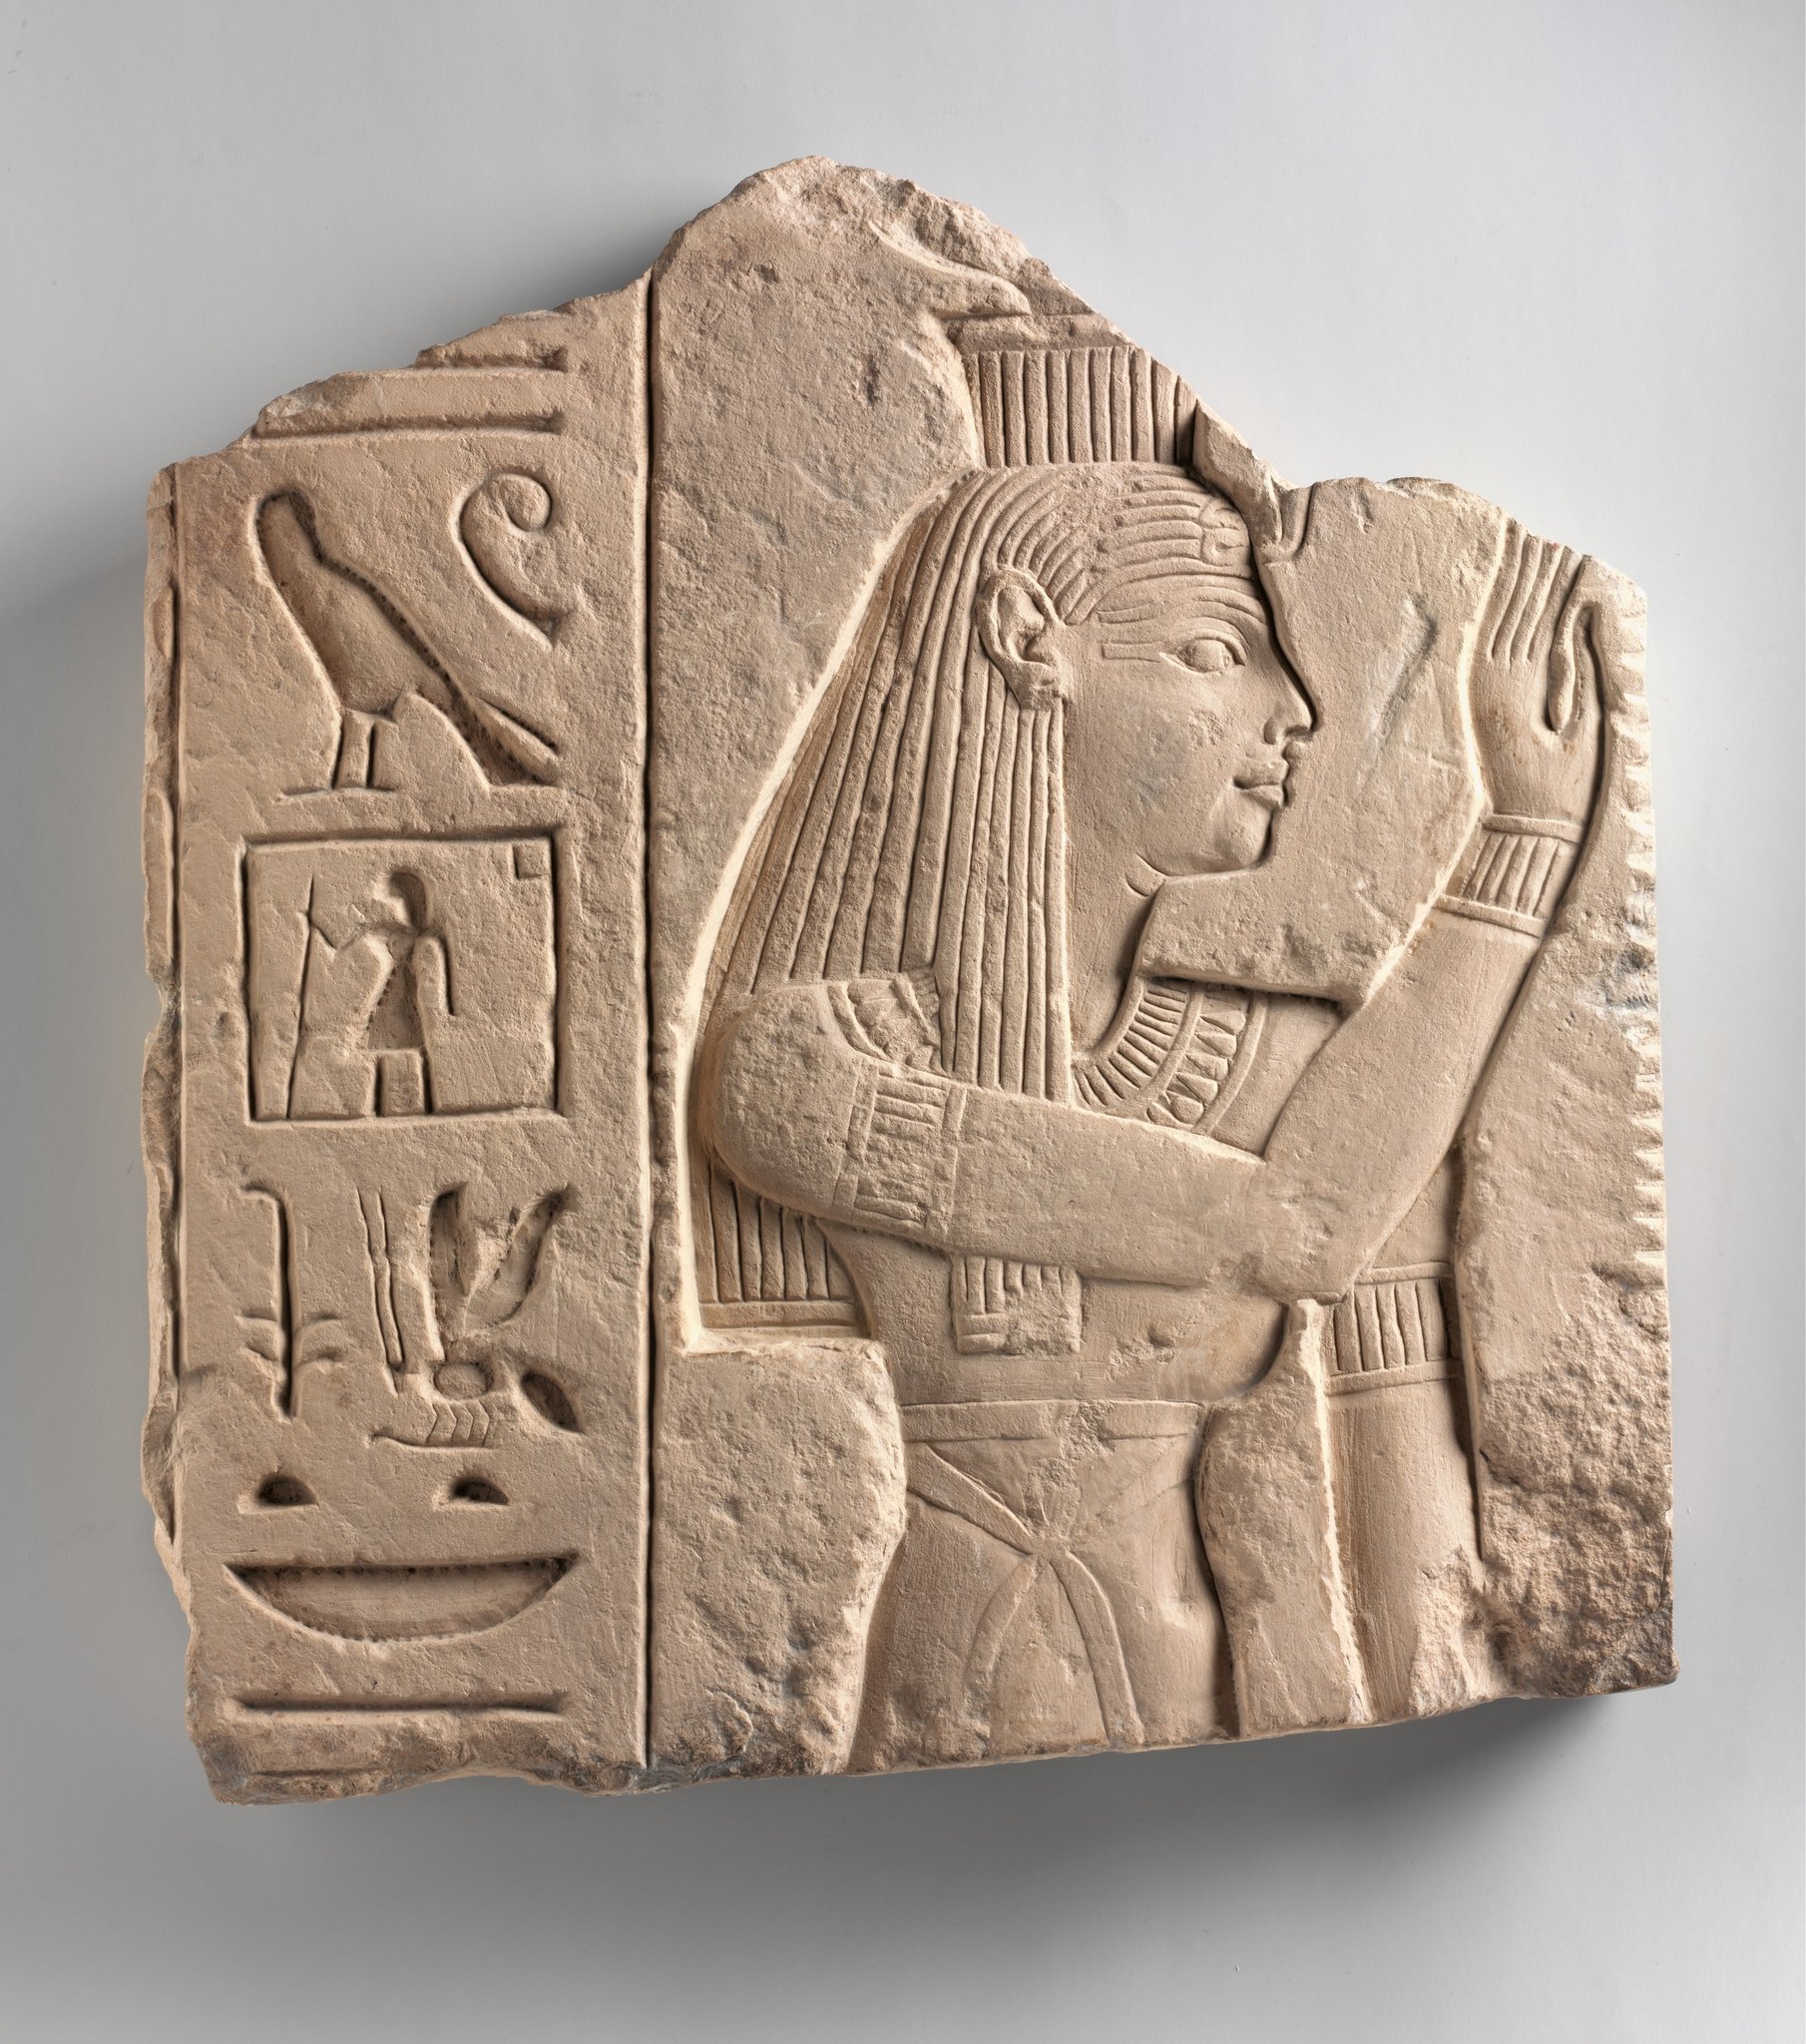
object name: relief, goddess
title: Relief of a goddess offering a palm rib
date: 825-773 BCE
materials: limestone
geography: egypt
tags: hieroglyphs,goddess